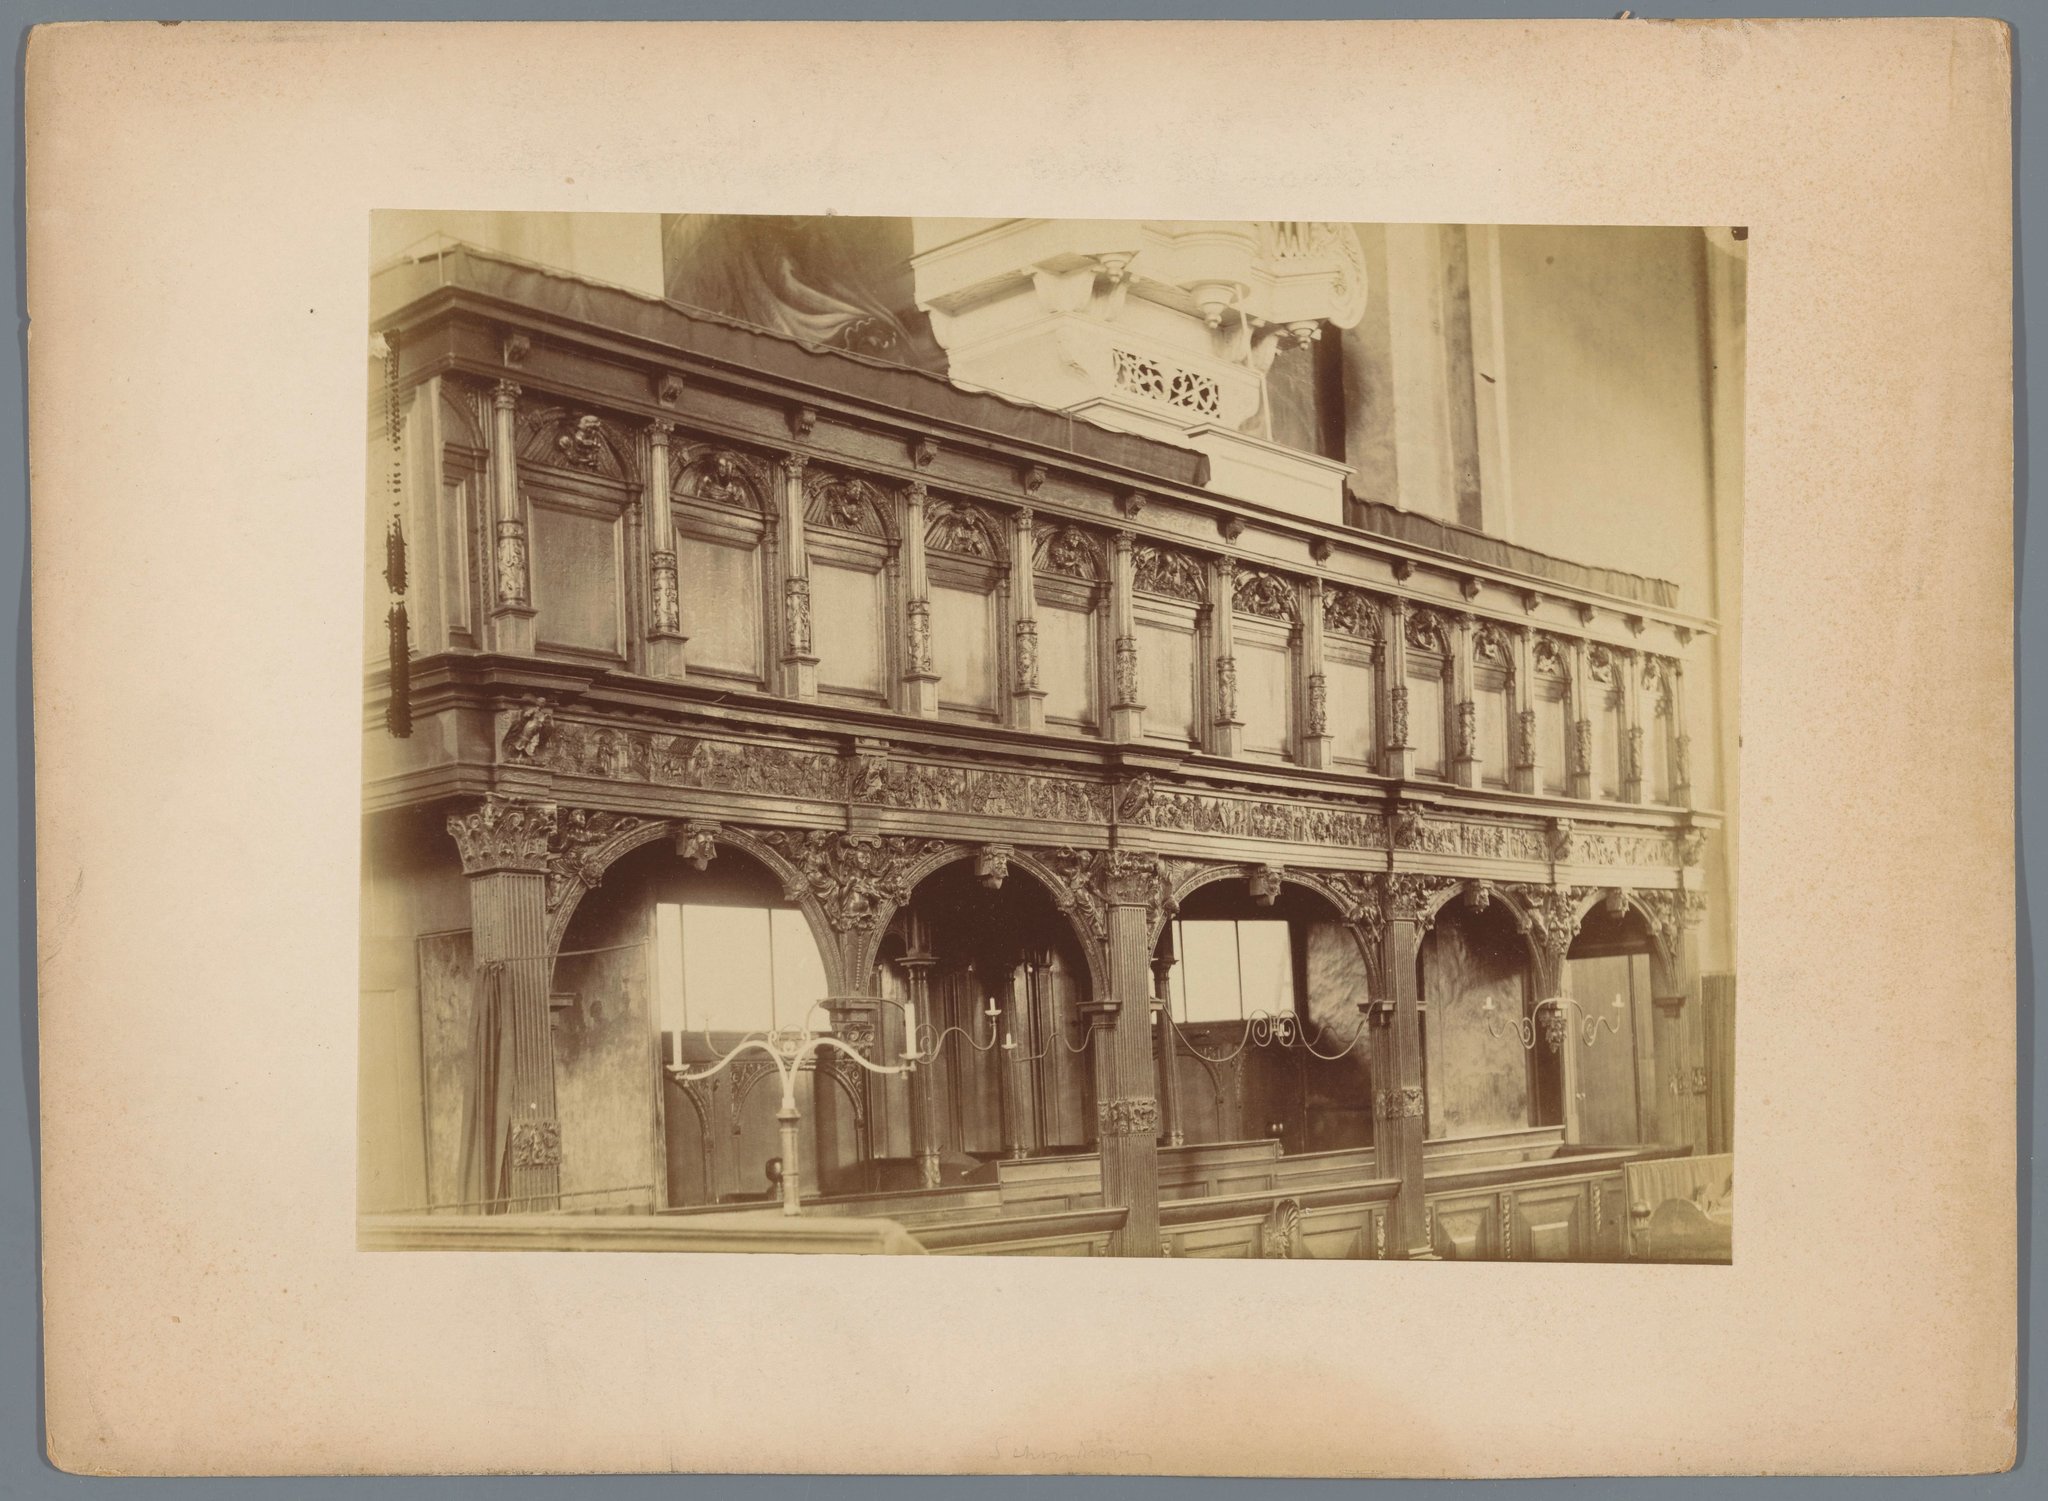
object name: photograph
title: Herenbank in de Bartholomeüskerk te Schoonhoven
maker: Anonymous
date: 1807-1891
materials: cardboard, photographic support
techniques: albumen print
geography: grote of bartholomeüskerk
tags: bench, interior of church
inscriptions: inscription: ‘Schoonhoven Regeeringsbank July 1891’, annotation, inscription: ‘neg. no 6242 foto no 6384’